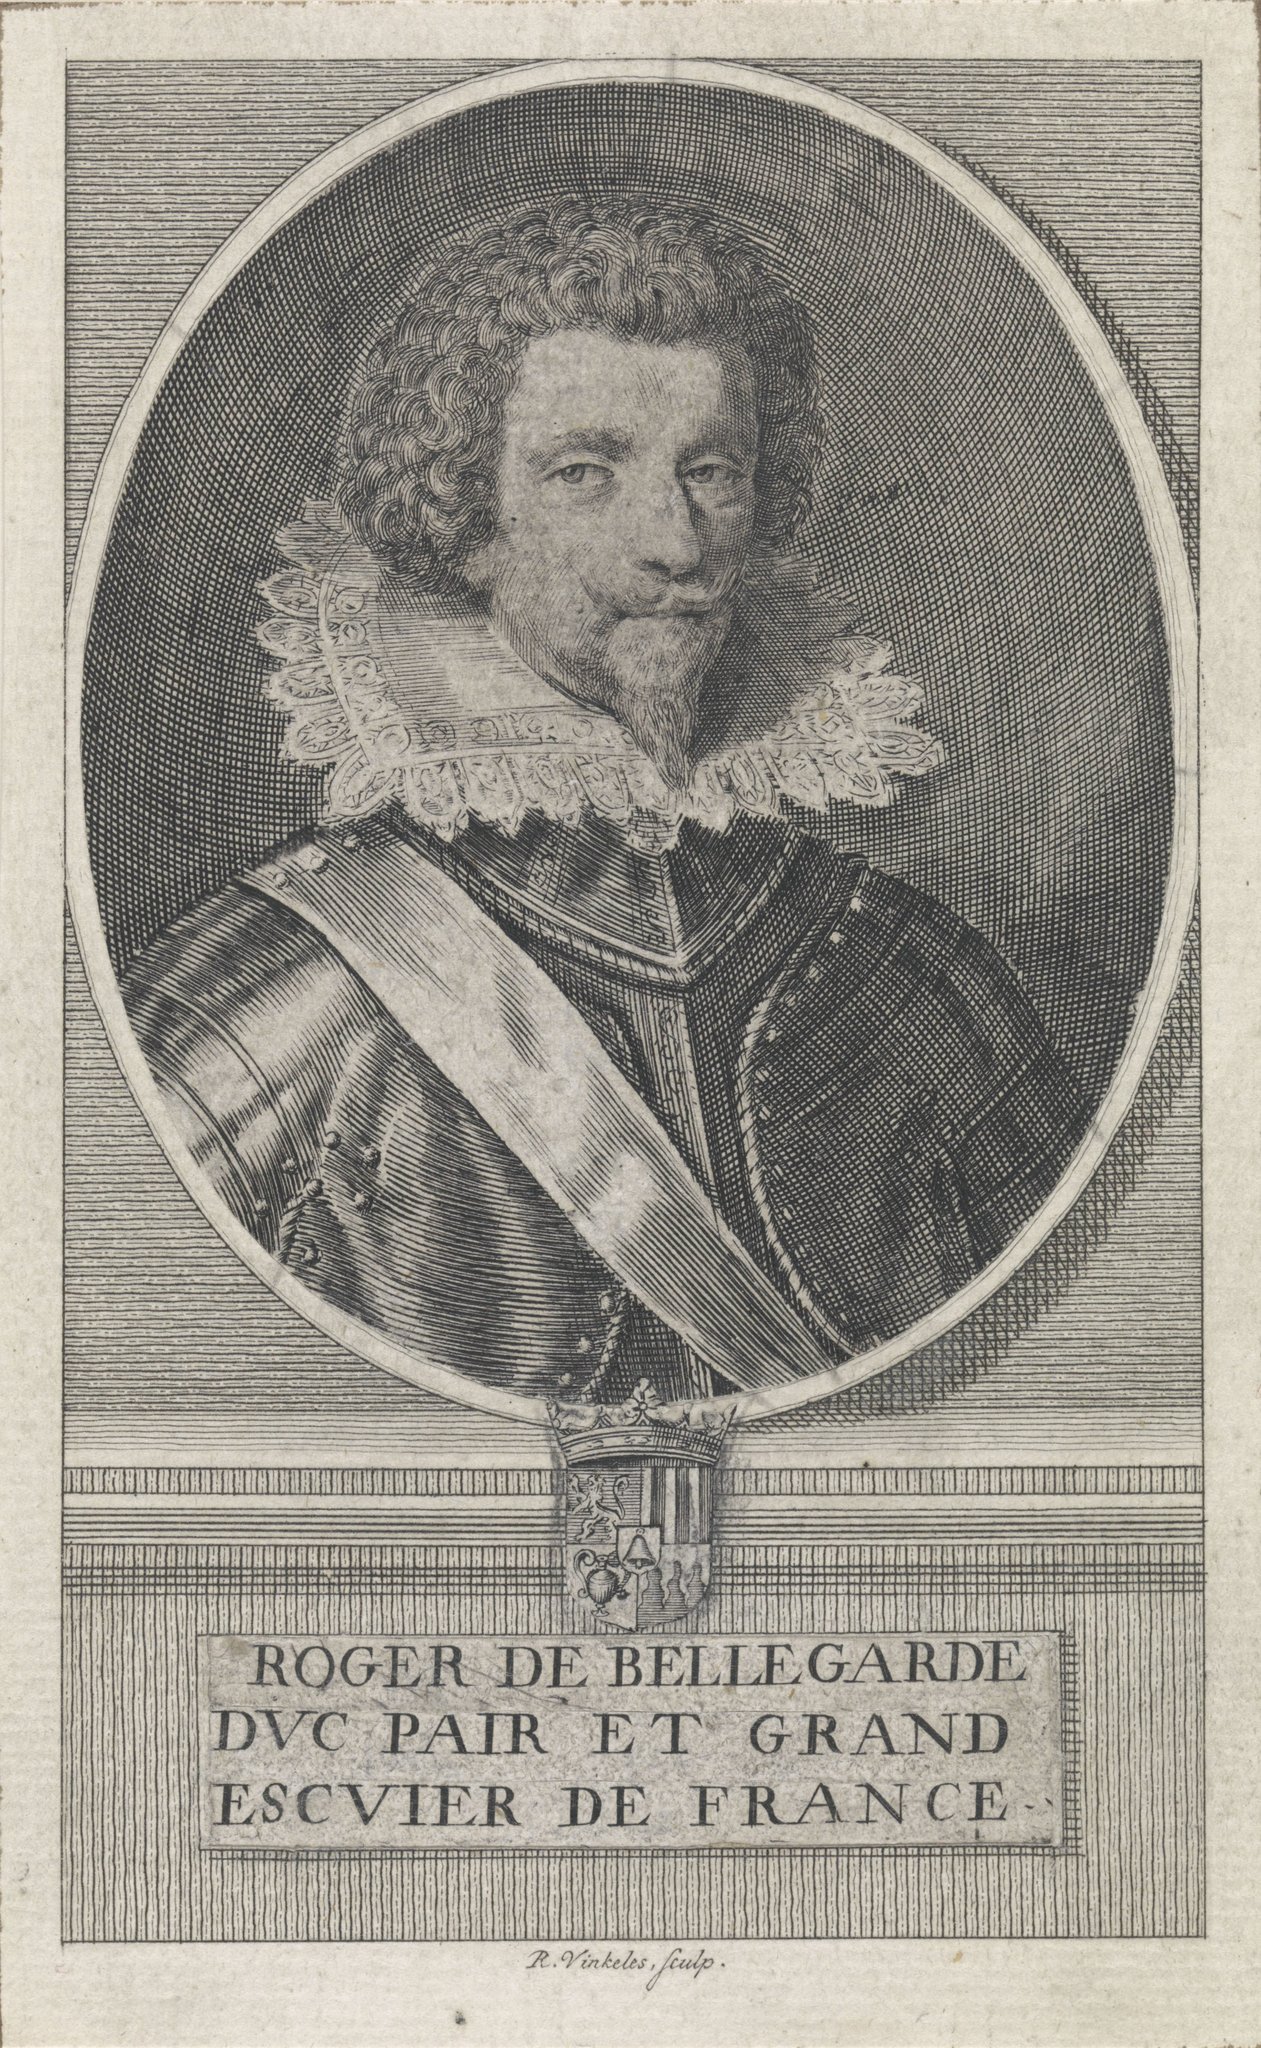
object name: print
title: Portret van de Franse hertog Roger de Bellegarde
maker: reinier vinkeles (i)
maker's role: draughtsman, print maker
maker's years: 1741-1816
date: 1770-1771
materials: paper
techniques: engraving, etching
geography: paris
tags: roger bellegarde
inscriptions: collector's mark: Lugt 2228